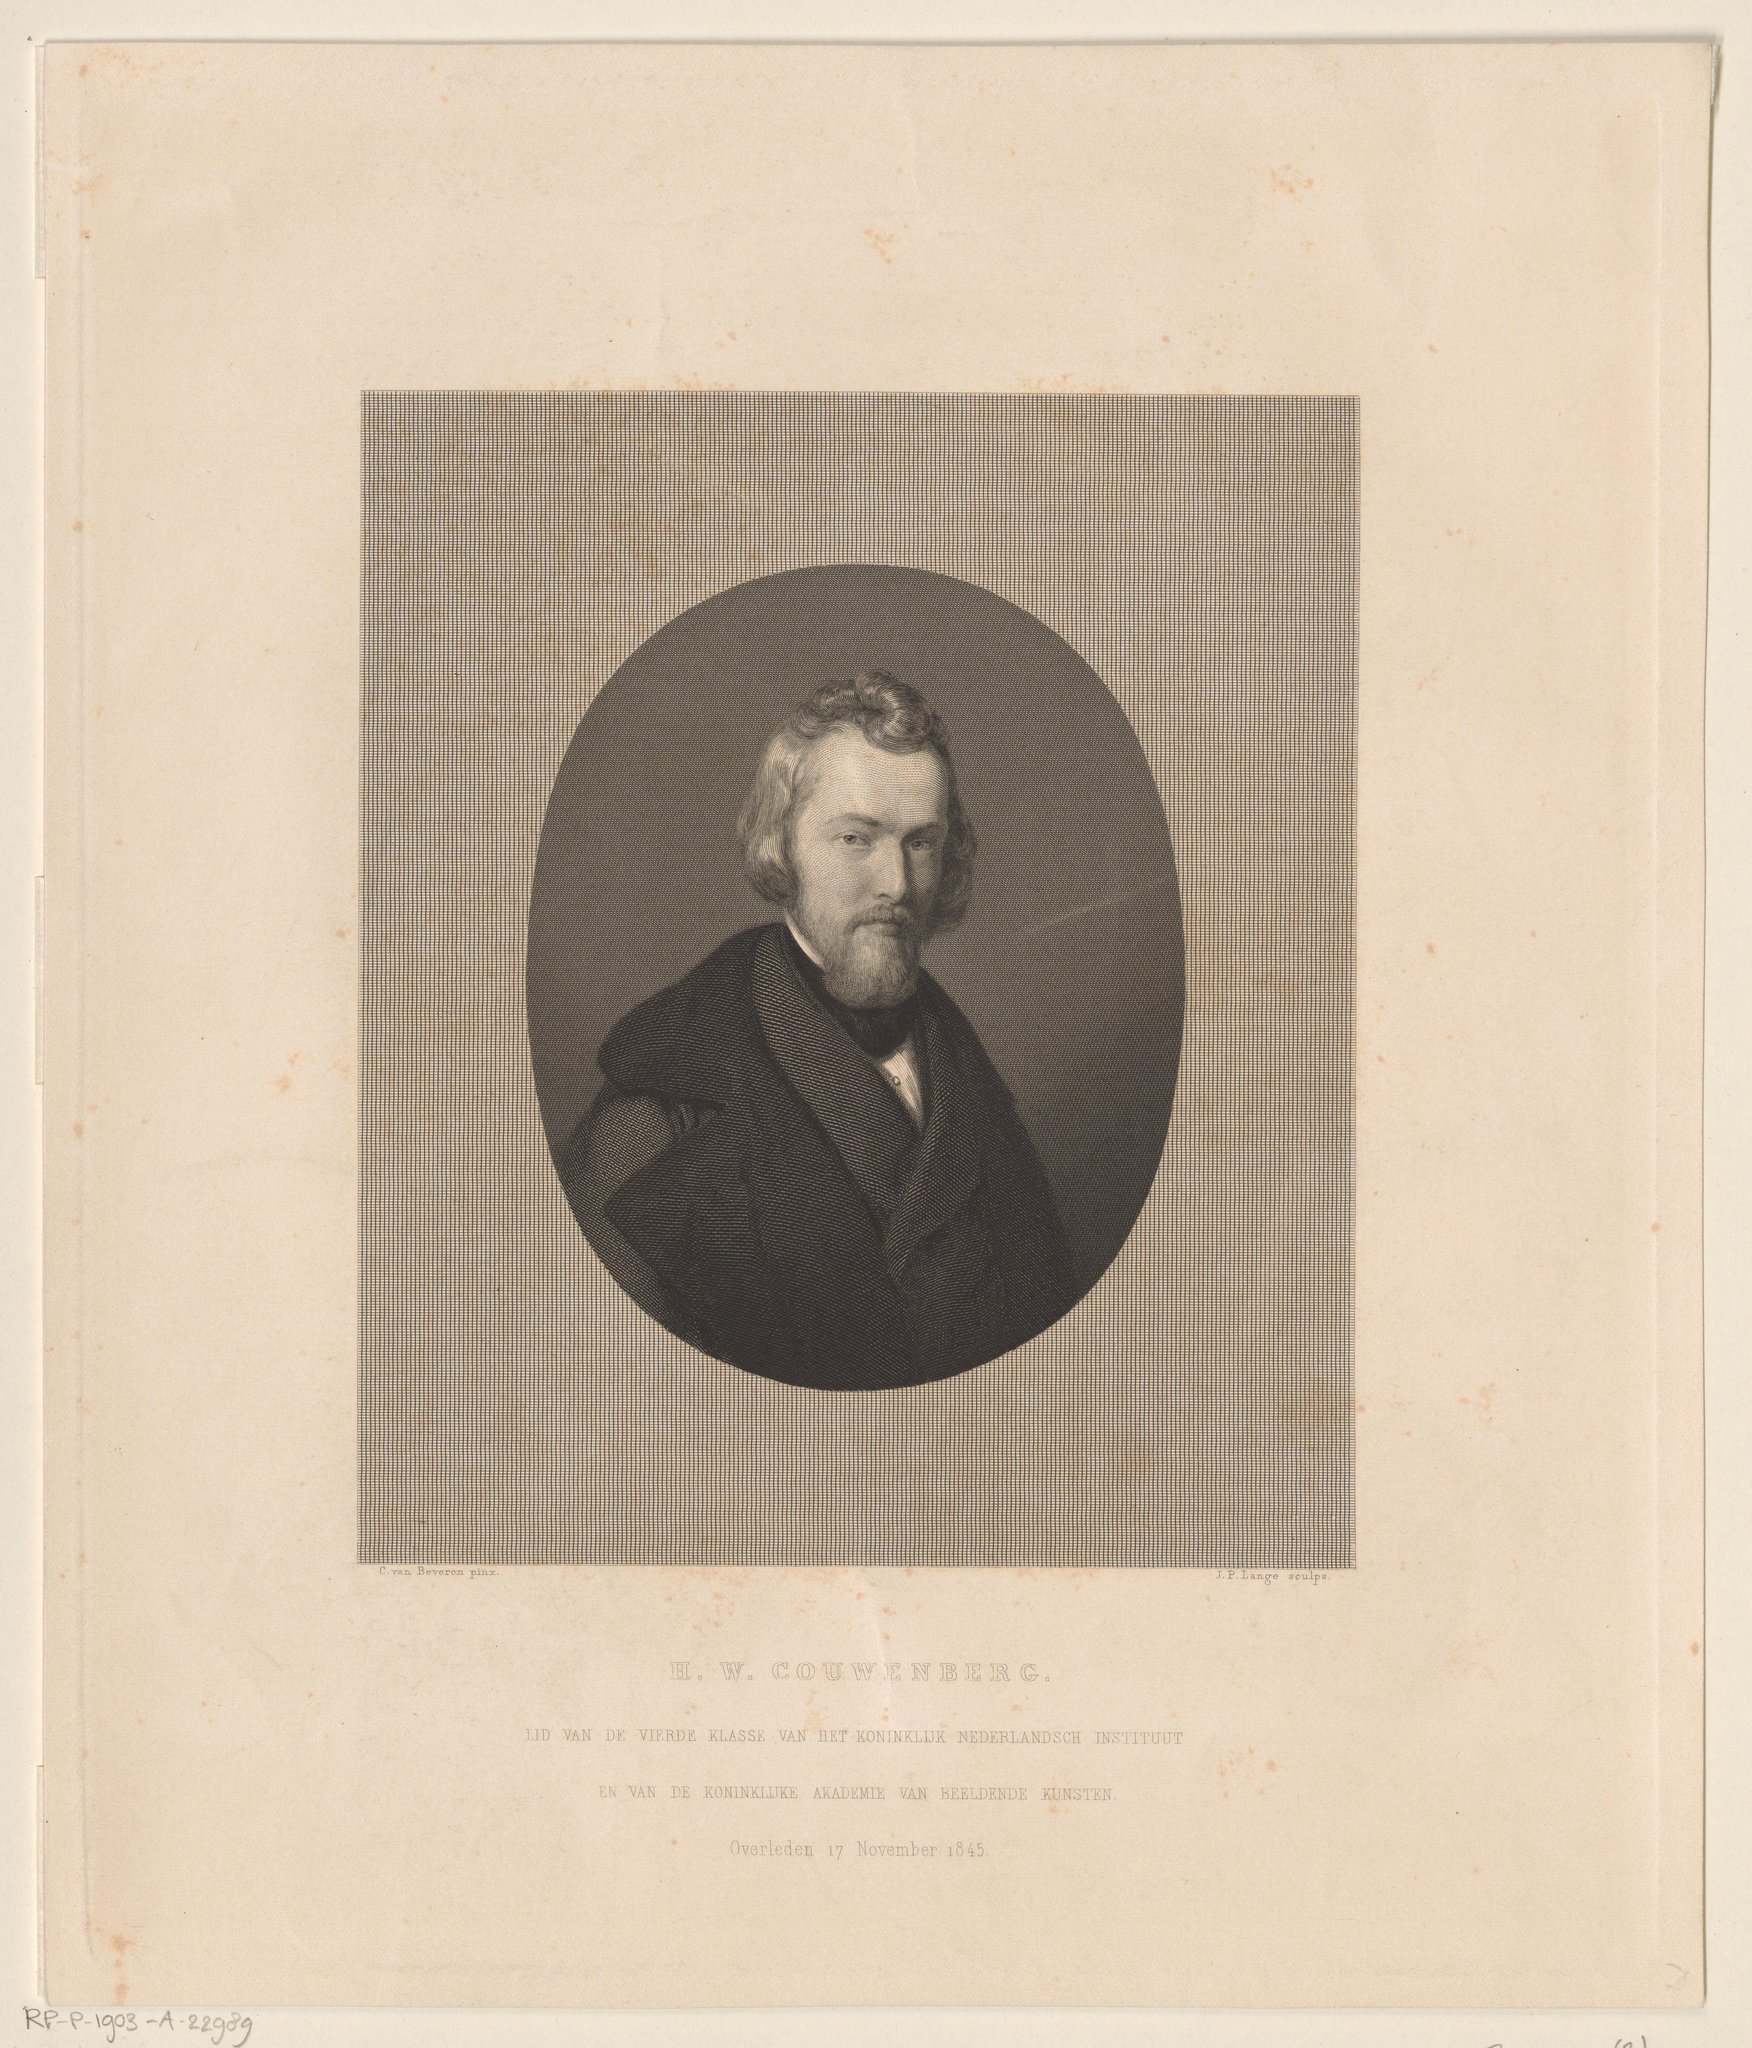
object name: print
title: Portret van Henricus Wilhelmus Couwenberg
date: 1845-1849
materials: paper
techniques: etching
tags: the hague, amsterdam, print maker, draughtsman, henricus wilhelmus couwenberg, historical persons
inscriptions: collector's mark: Lugt 2228